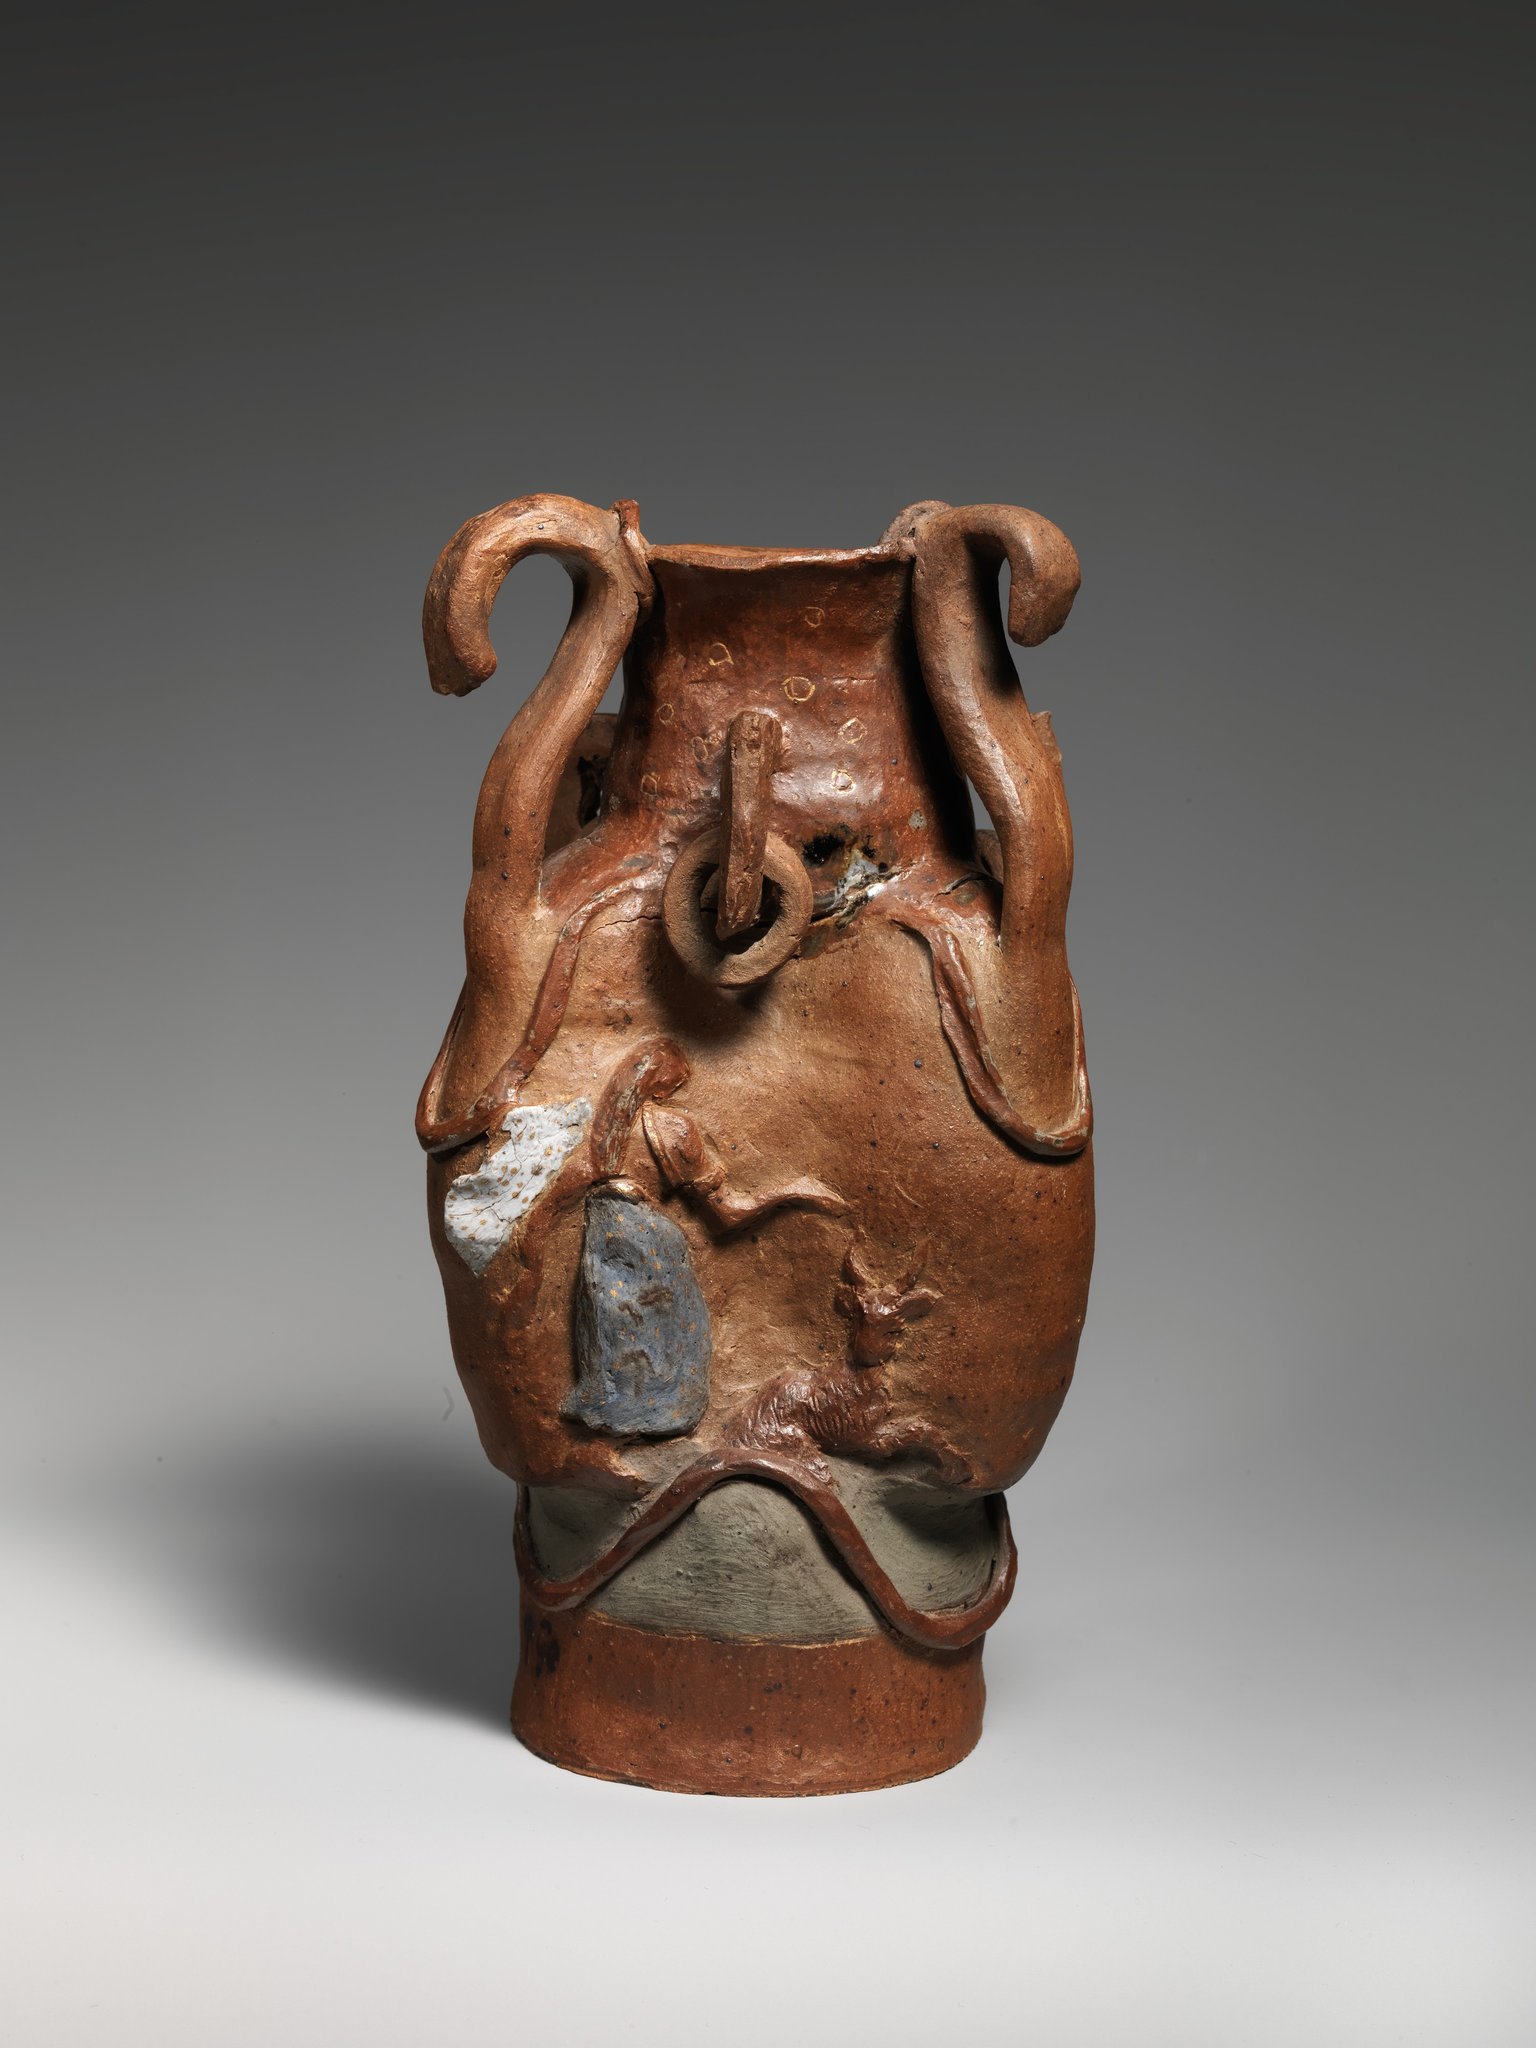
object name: vessel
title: Vessel with Women and Goats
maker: paul gauguin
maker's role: maker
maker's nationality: french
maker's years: 1848-1903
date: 1887-1889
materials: stoneware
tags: women,goats